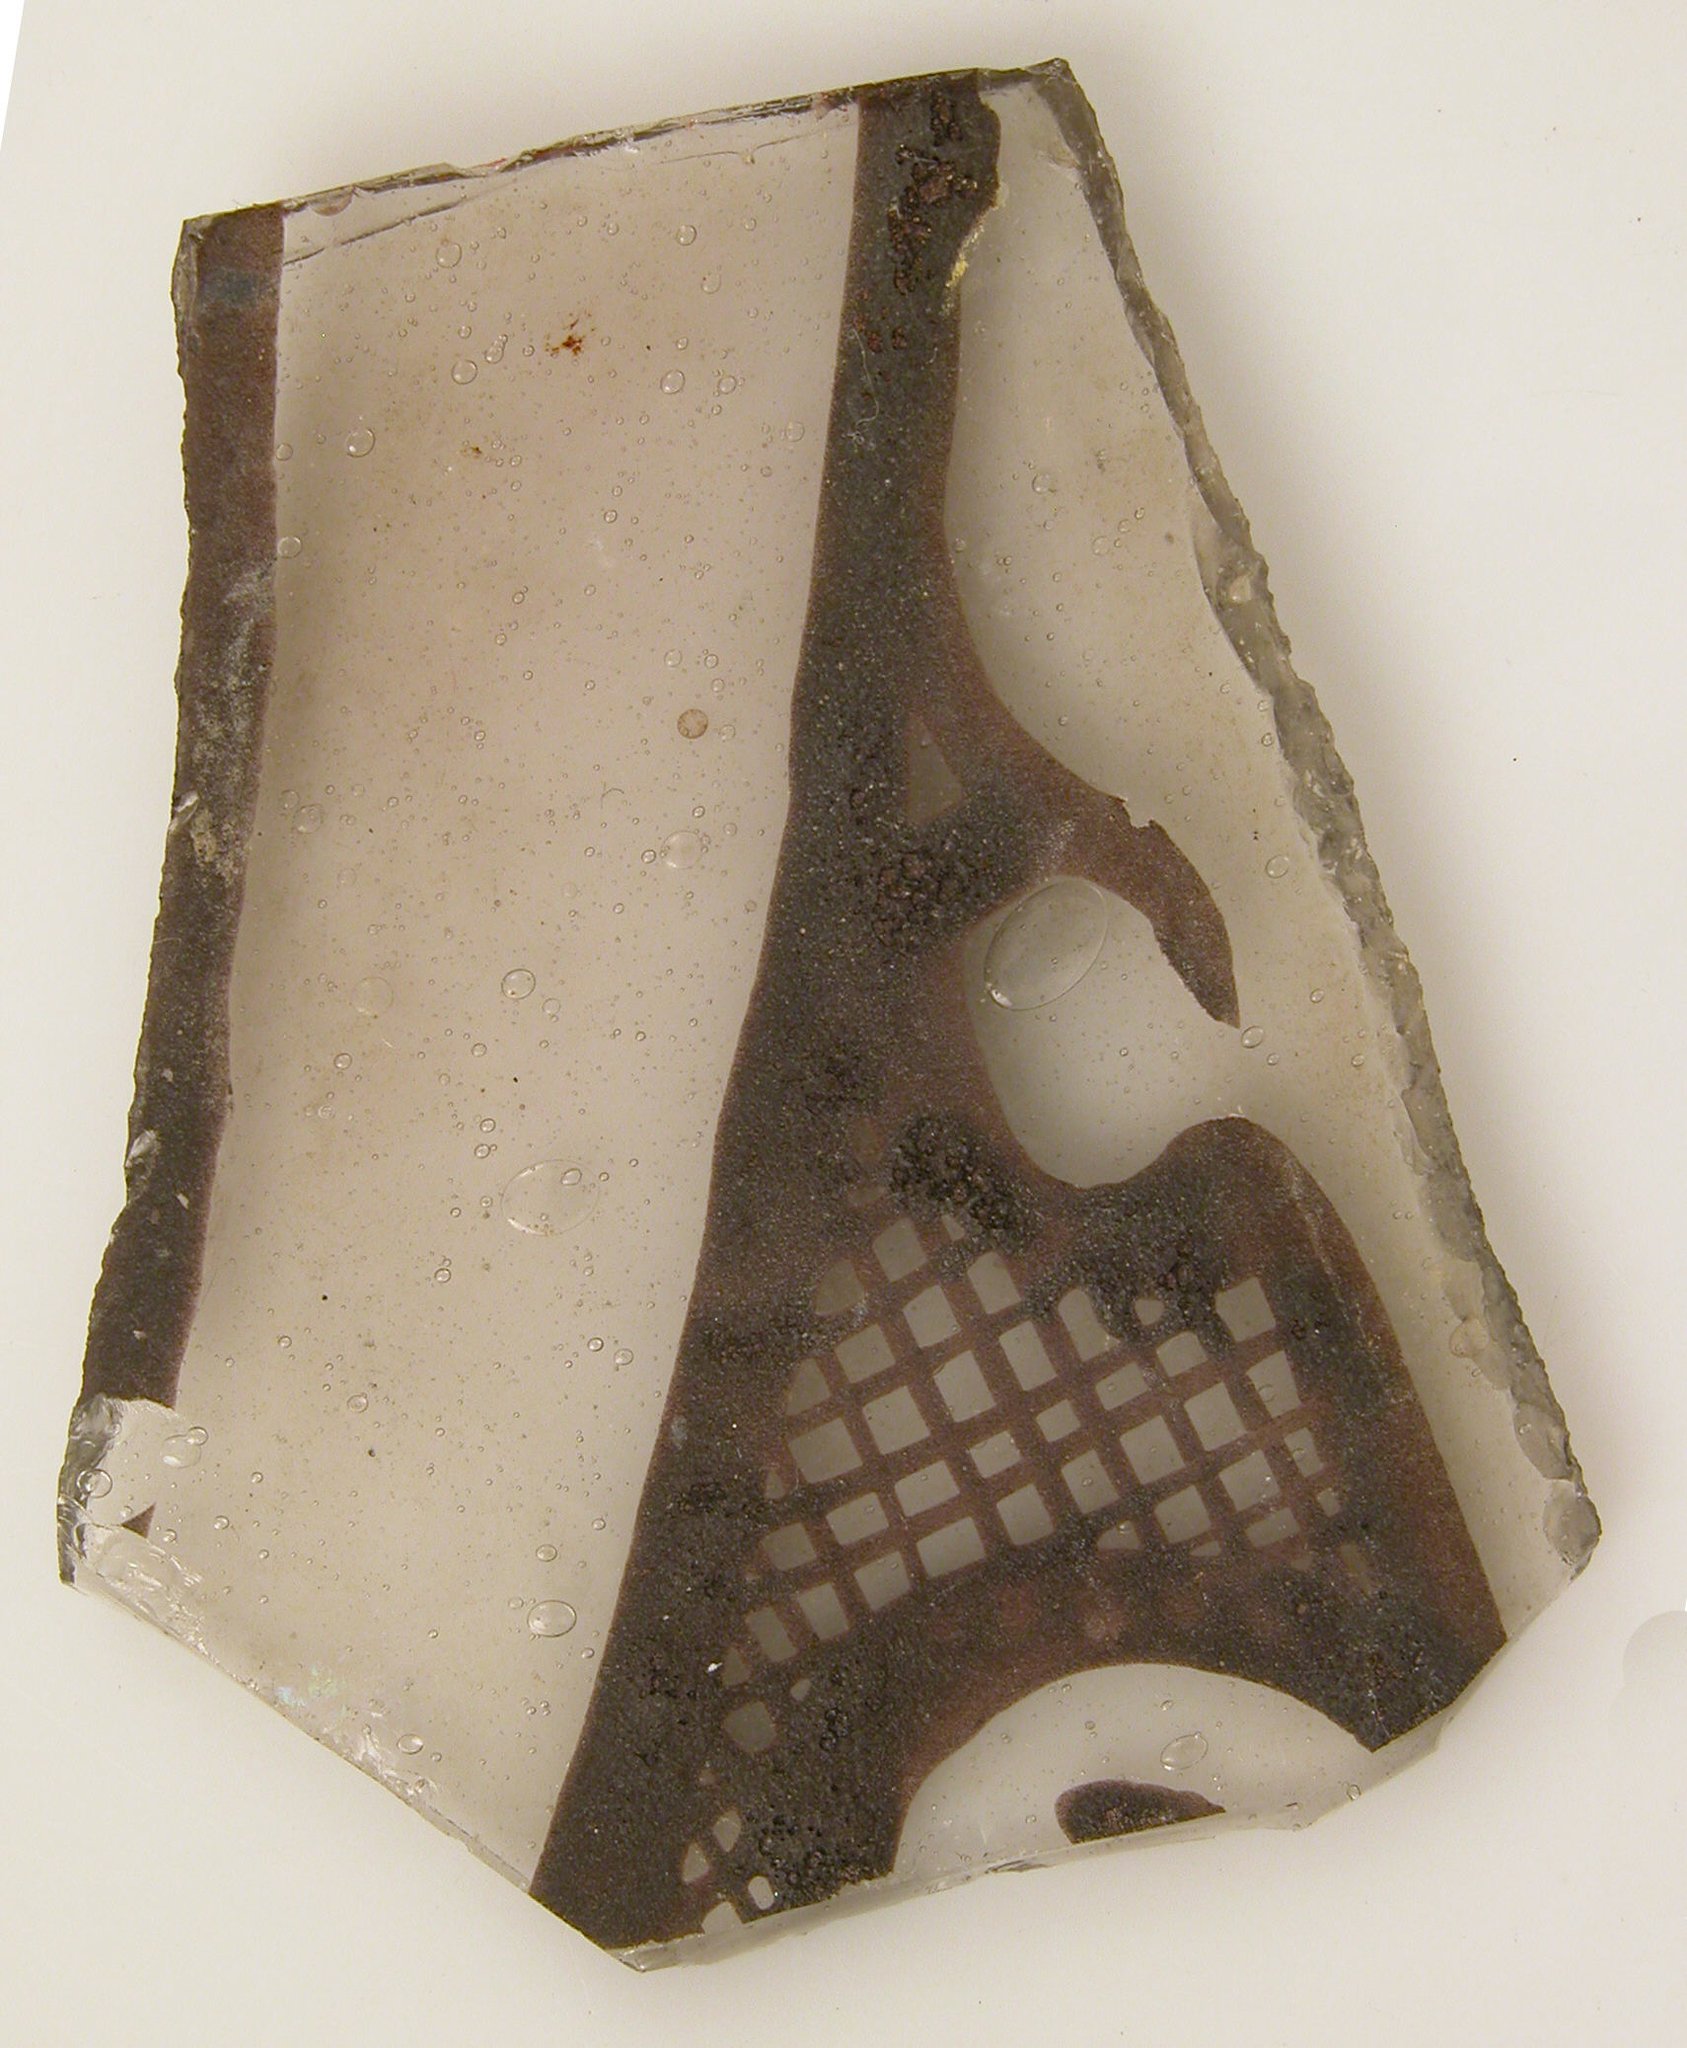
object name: fragment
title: Grisaille Fragment with Plant Motif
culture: crusader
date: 1220-1272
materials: glass